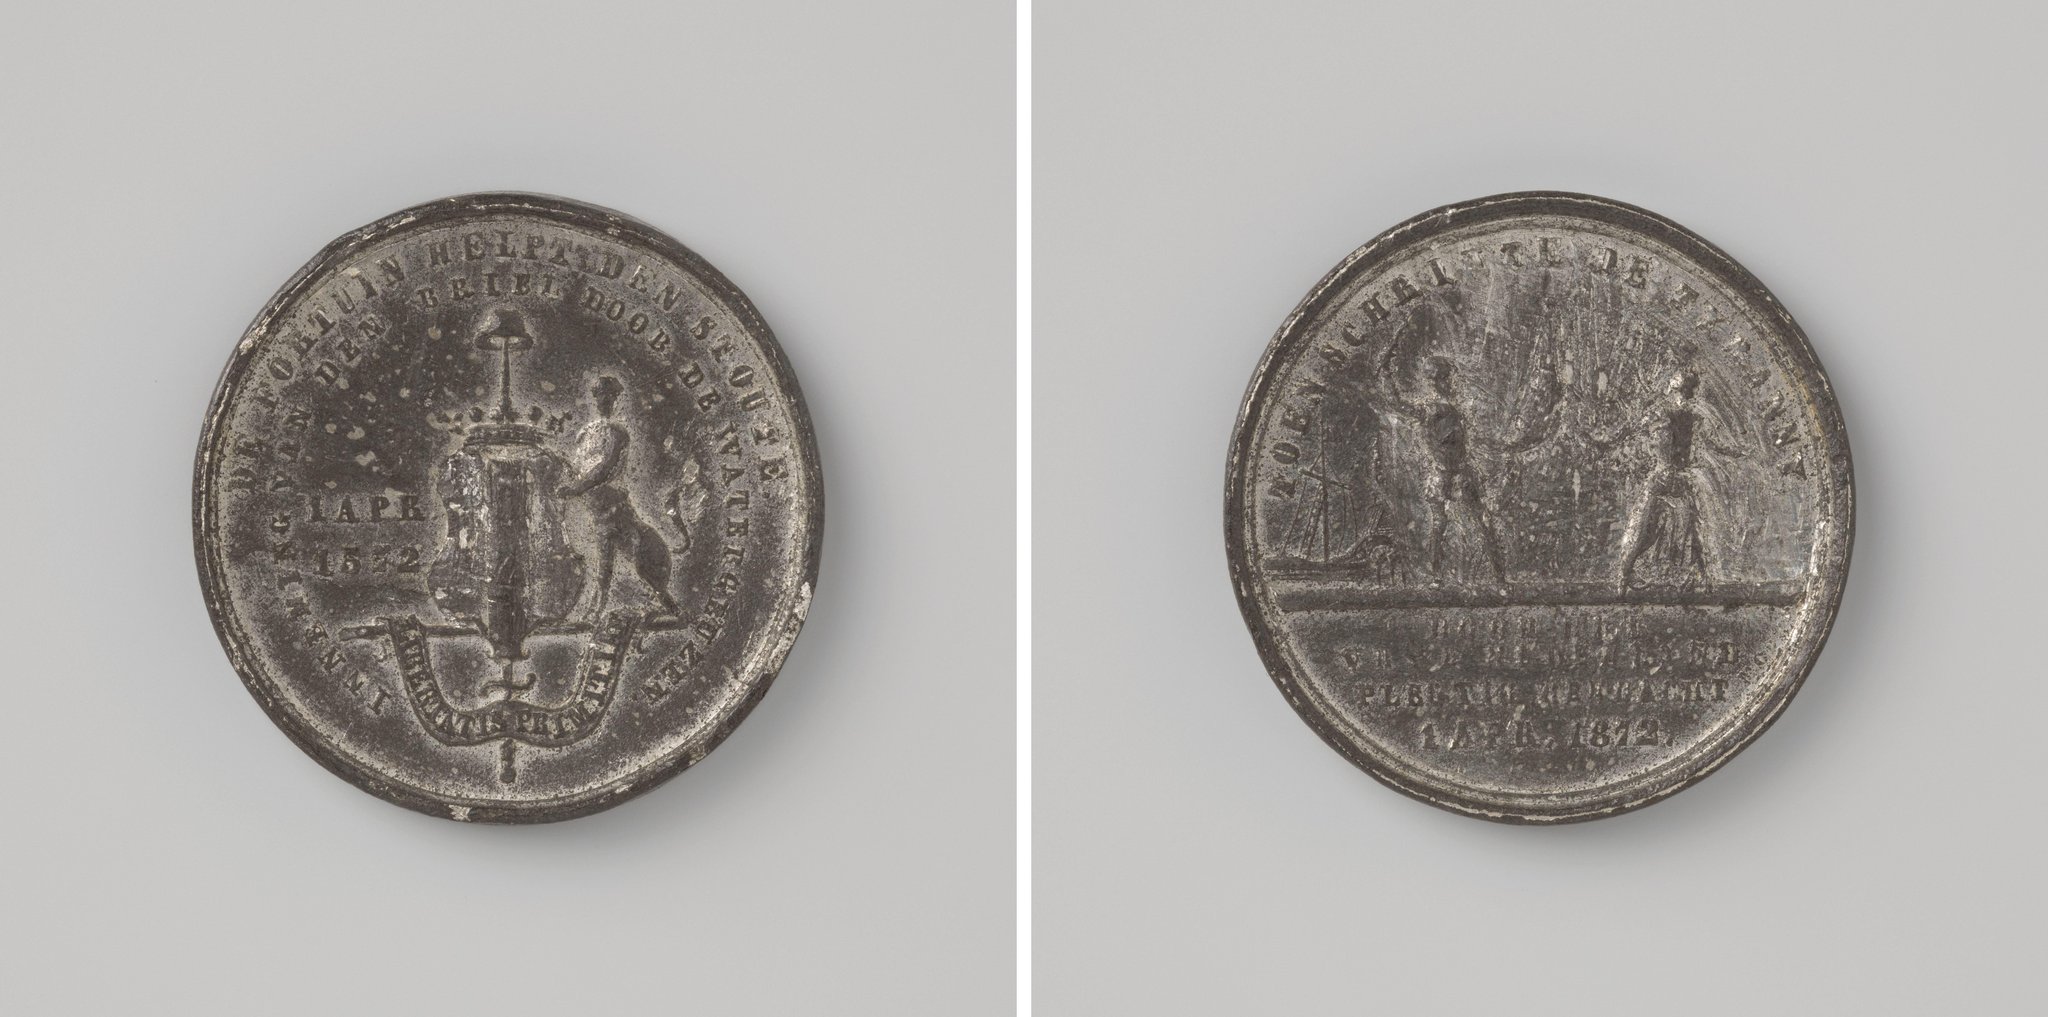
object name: history medal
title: Driehonderdjarige herdenking van de inname van Den Briel door de Watergeuzen 1872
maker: moses cohen de vries junior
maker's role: diamantslijper, graveur, medailleur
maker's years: 1807-1883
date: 1872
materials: tin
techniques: striking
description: Tinnen penning, op de voorzijde het gekroonde wapenschild van Den Briel, met rechts een centauer als drager, op een zwaard met vrijheidshoed, op een basis waaraan een tekstlint hangt, en naast de datum 1 APR 1572, met dubbel omschrift, op de keerzijde een watergeus met zwaard en vaandel die de Tyrannie, als vrouw met zwaard en vallend juk, verdrijft, met omschrift en afsnedetekst.